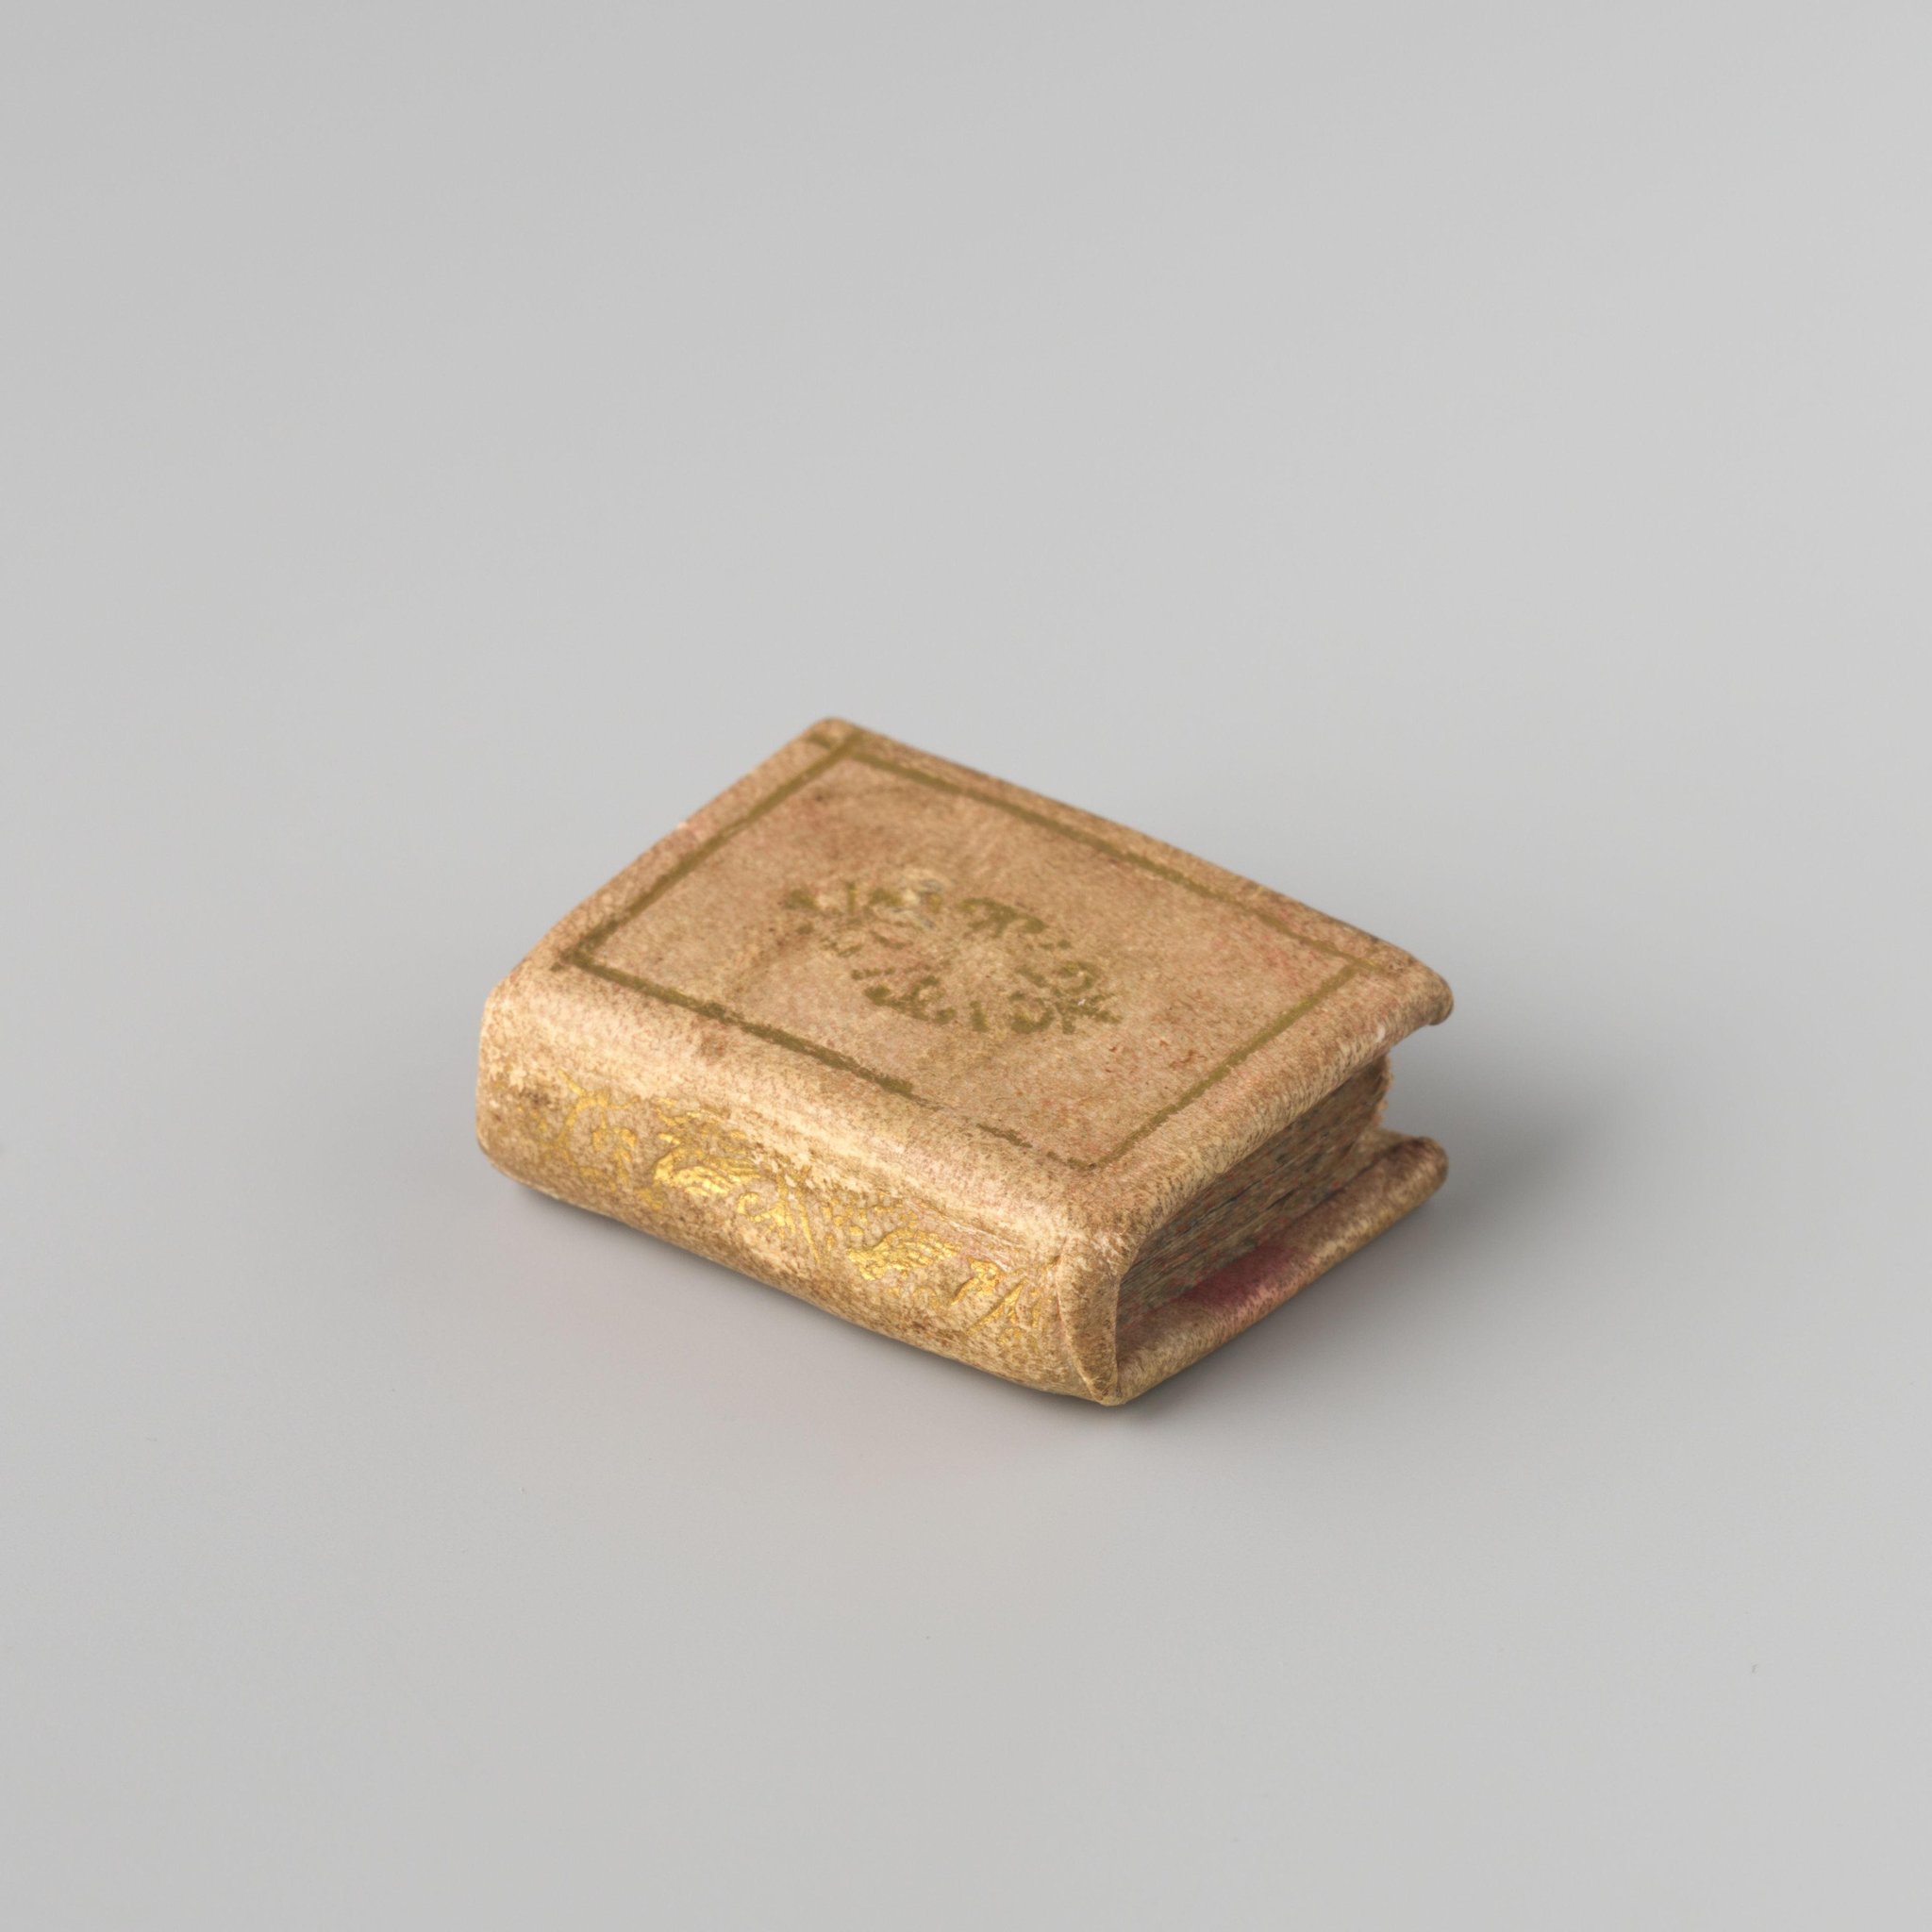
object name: book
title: Boek met legeropstellingen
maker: Anonymous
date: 1690-1710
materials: gold, leather, paper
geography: amsterdam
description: Boek met legeropstellingen. Ingebonden in roze gekleurd schapenleer met goudopdruk.